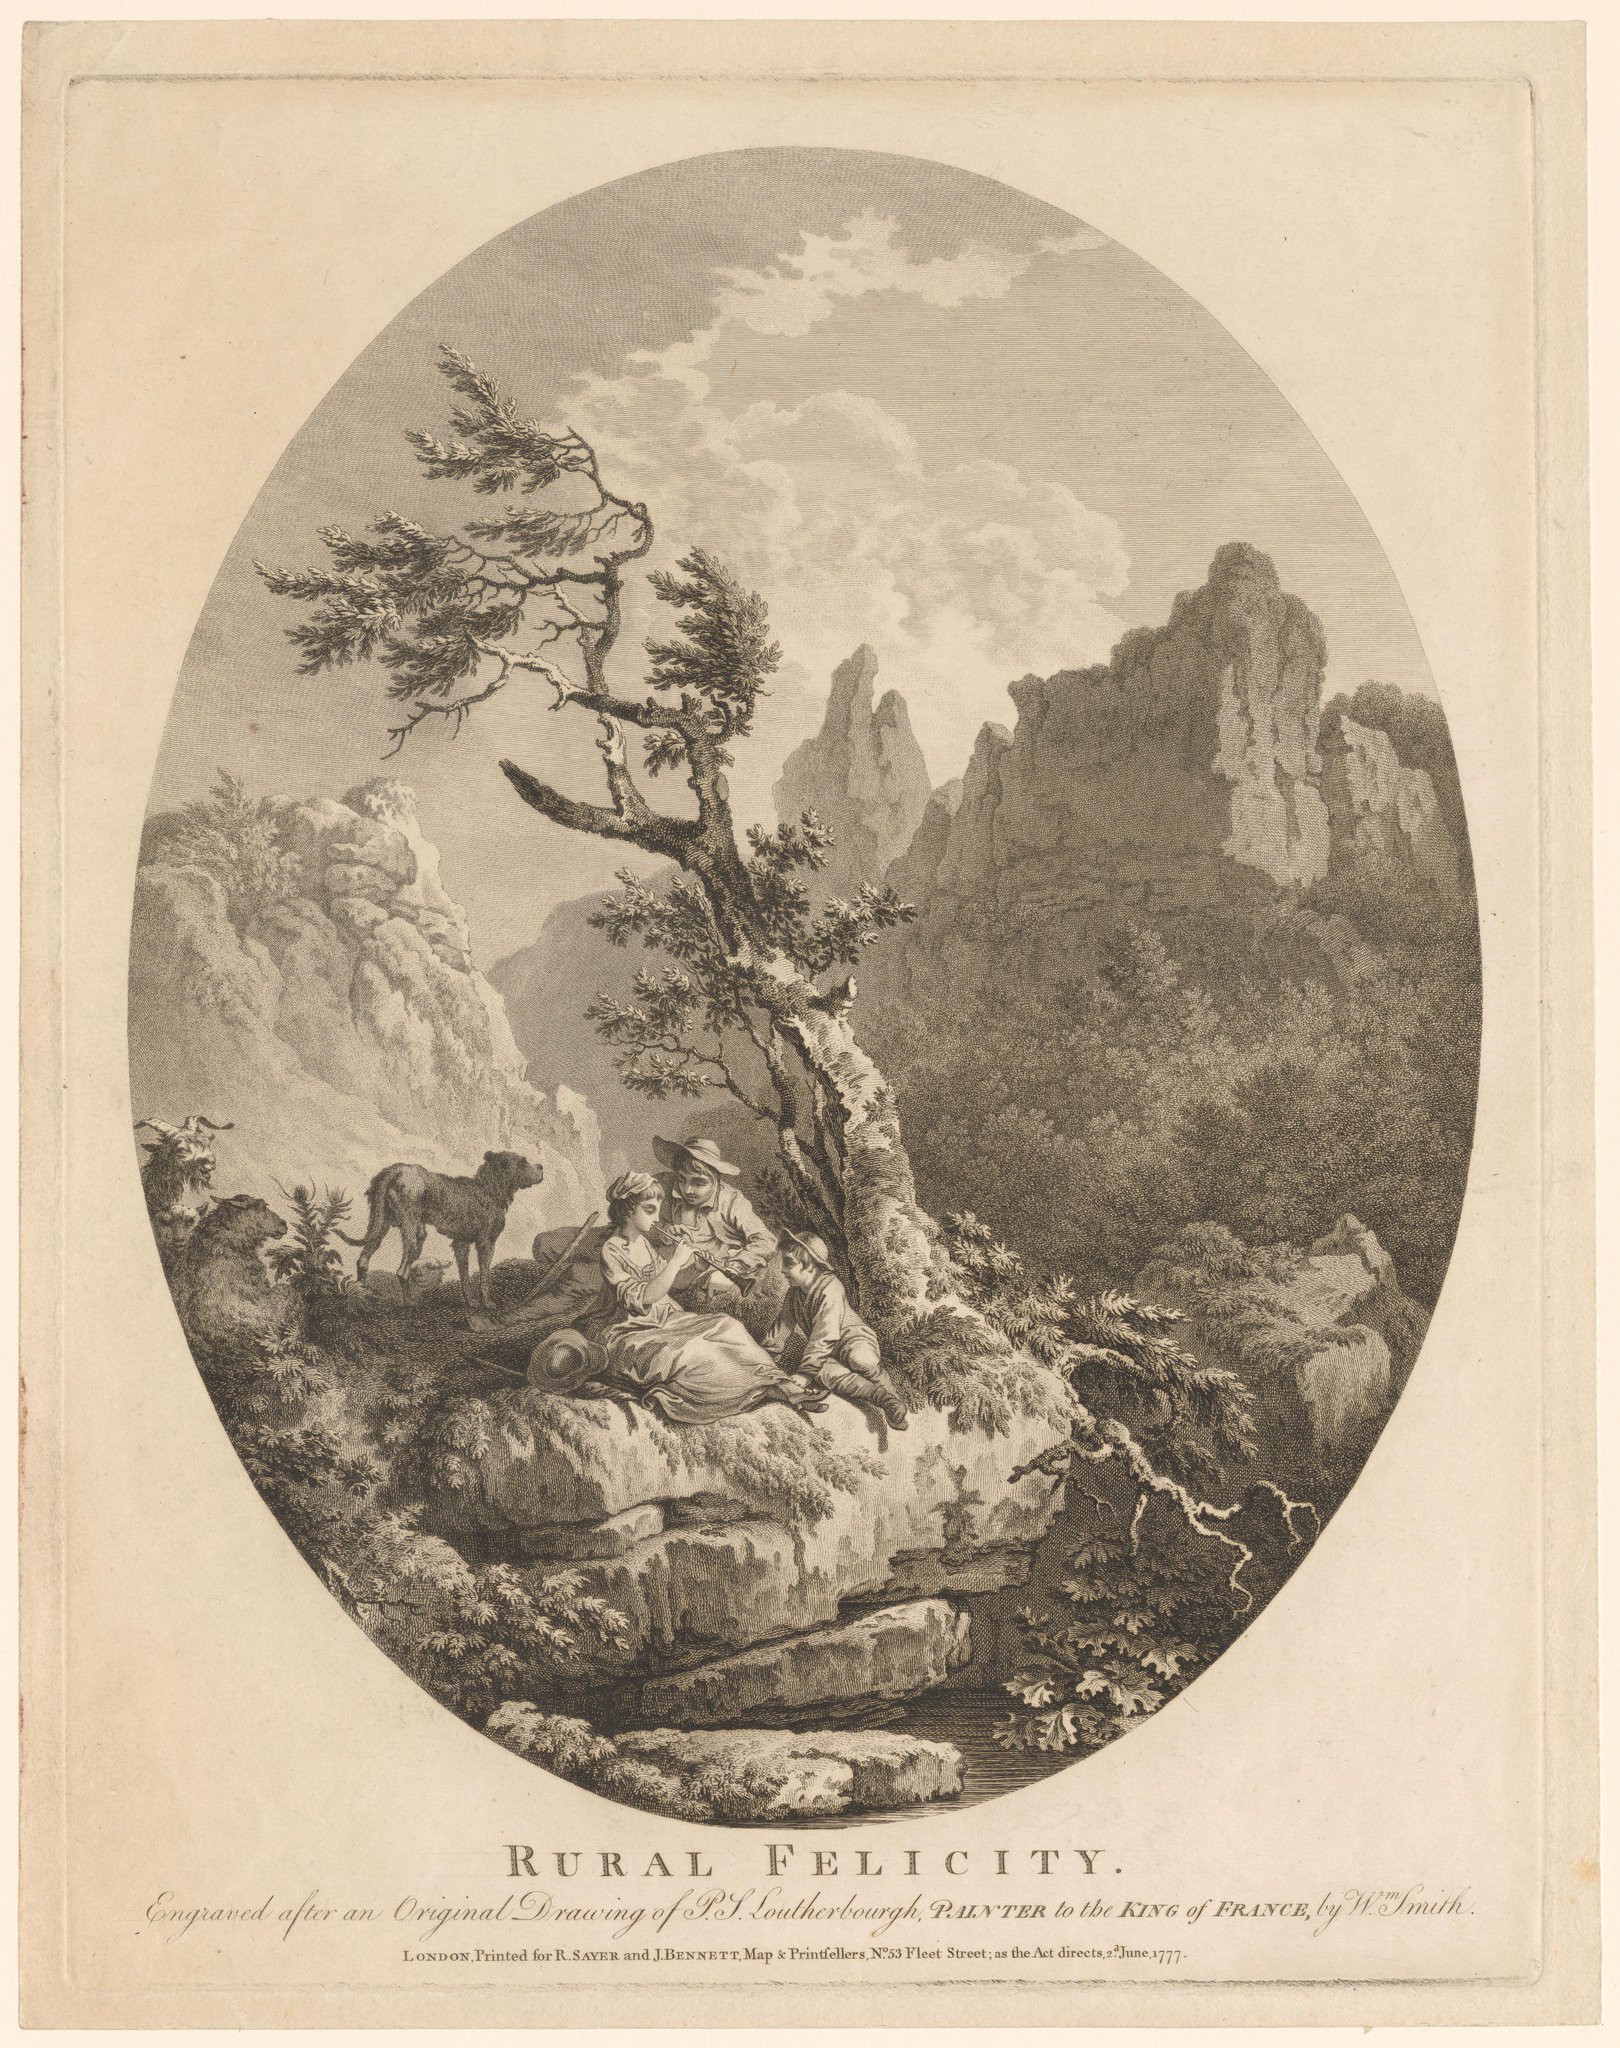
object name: print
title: Rural Felicity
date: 1706-1777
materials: paper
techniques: etching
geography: london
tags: listening to music - cc - out of doors, clarinet, bassoon, oboe, shawm - cc - out of doors, rock-formations, dog, mountains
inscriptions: collector's mark: Lugt 2228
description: Prent vormt een paar met 'Sportive Innocence', zie RP-P-OB-19.008.